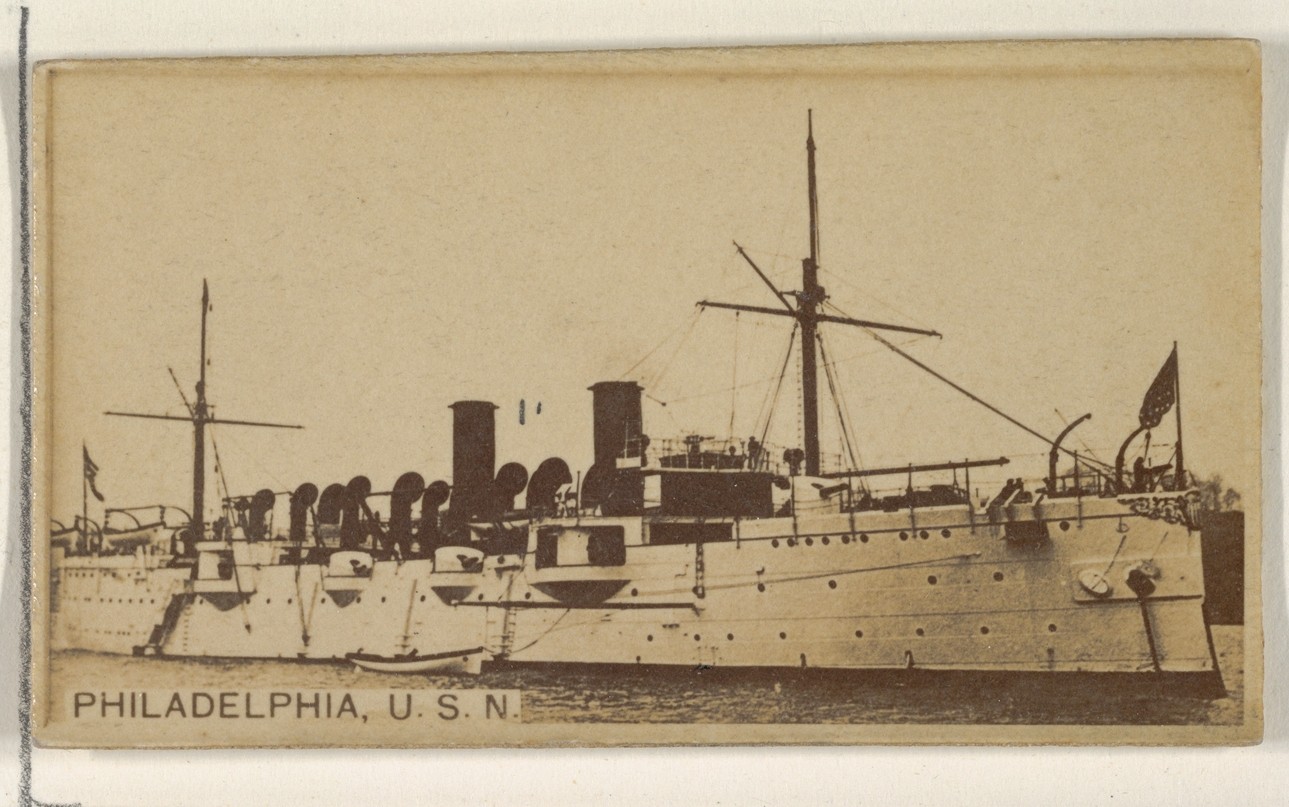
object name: photograph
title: Philadelphia, U.S.N., from the Famous Ships series (N50) for Virginia Brights Cigarettes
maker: allen & ginter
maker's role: publisher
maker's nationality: american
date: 1895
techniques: albumen silver print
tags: ships